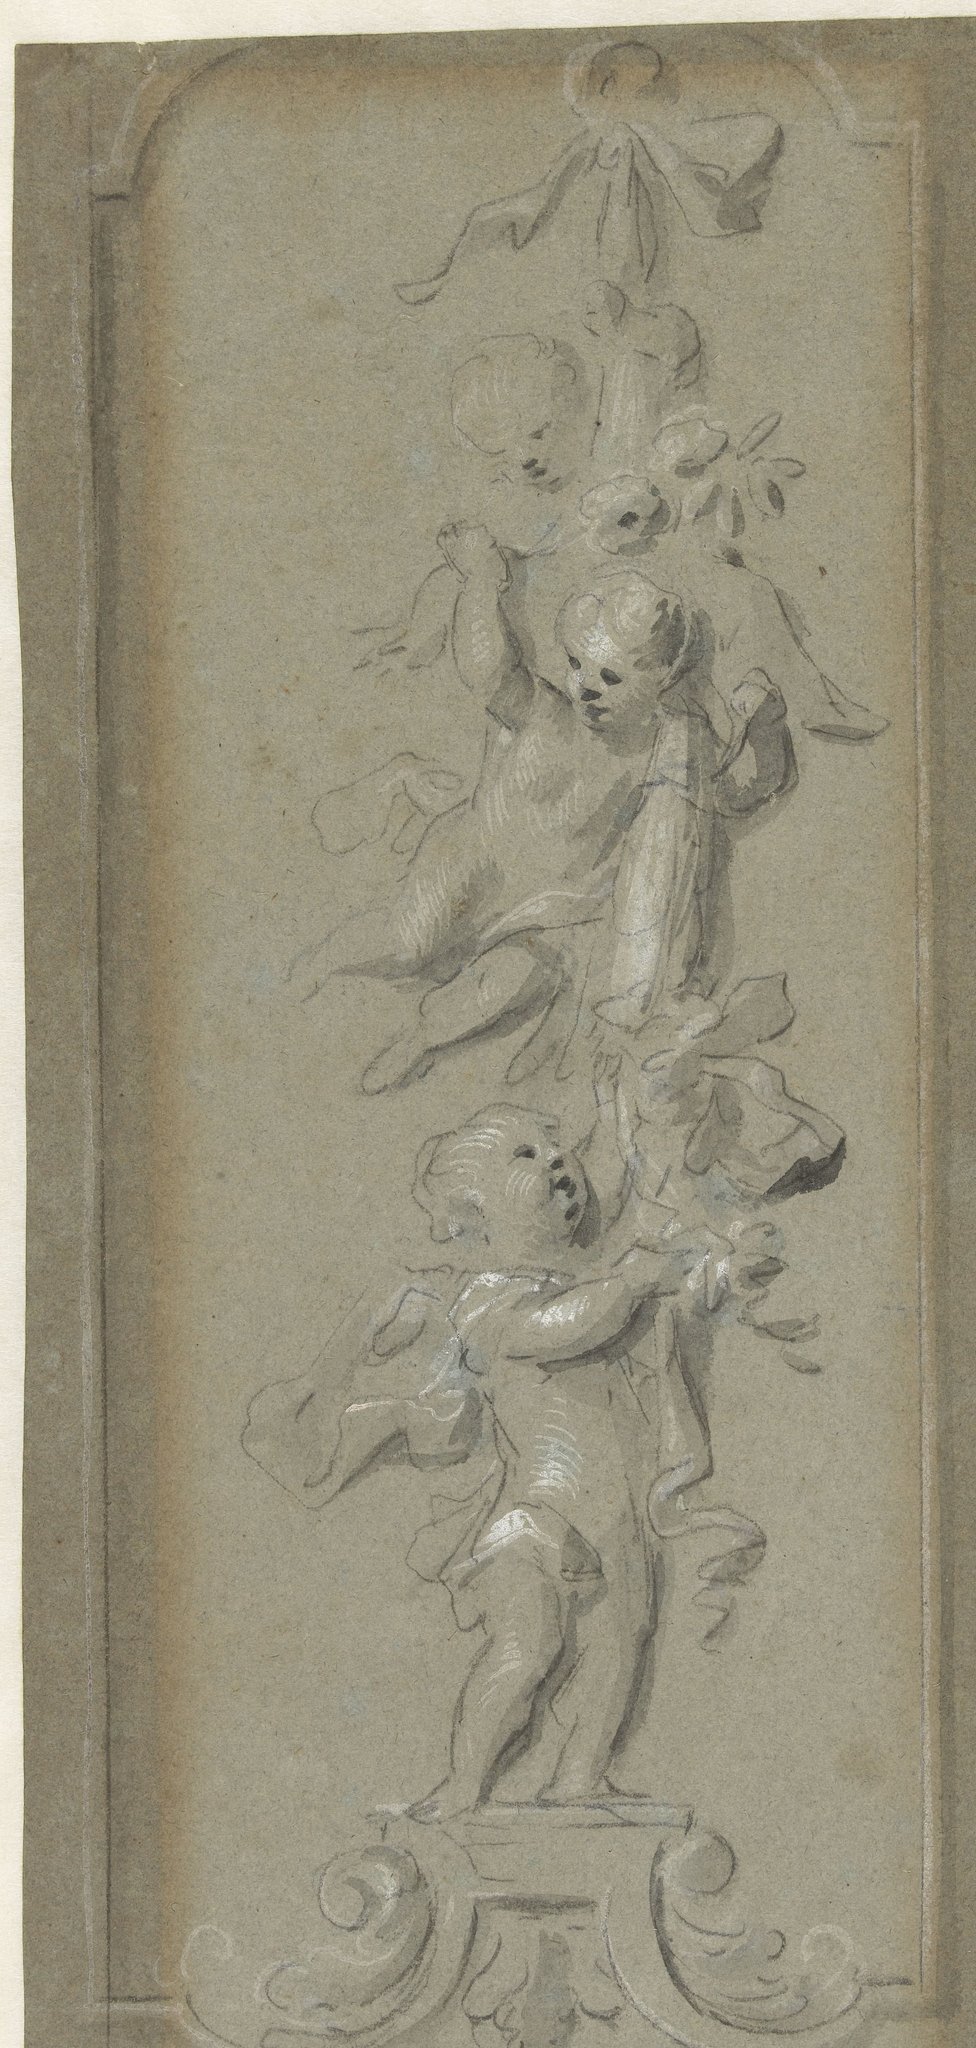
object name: drawing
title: Ontwerp voor een wandbespanning met drie putti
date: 1705-1804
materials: chalk, paint, graphite, ink, paper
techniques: brush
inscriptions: signature: ‘J de Wit’